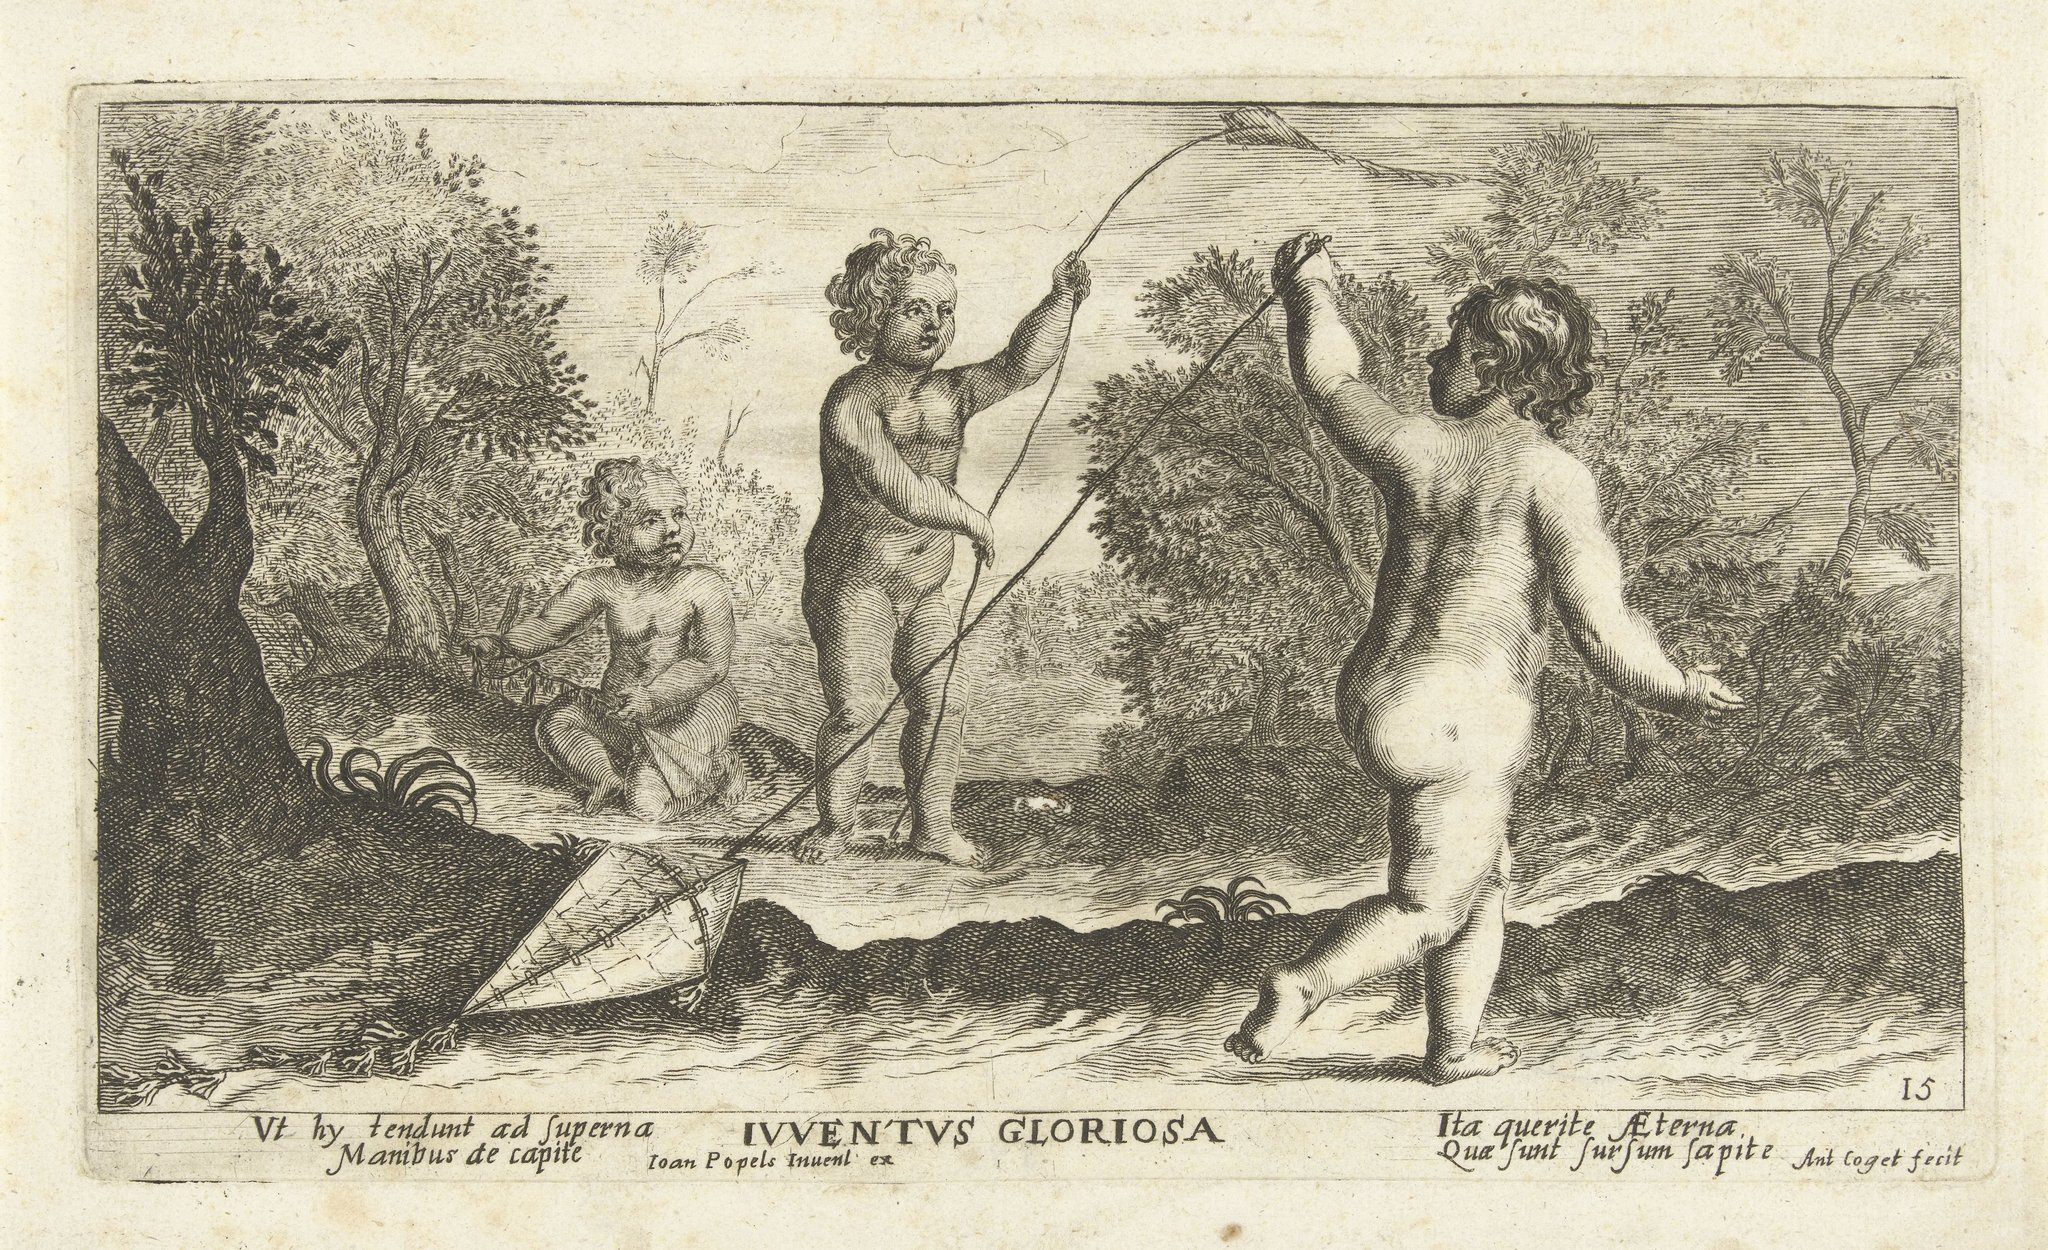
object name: print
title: Kinderen aan het vliegeren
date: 1645-1670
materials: paper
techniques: engraving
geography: antwerp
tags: youth, adolescent, (flying a) kite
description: Drie naakte kinderen laten vliegers opstijgen. Blad 15 uit de reeks Crepundia Moralisata.